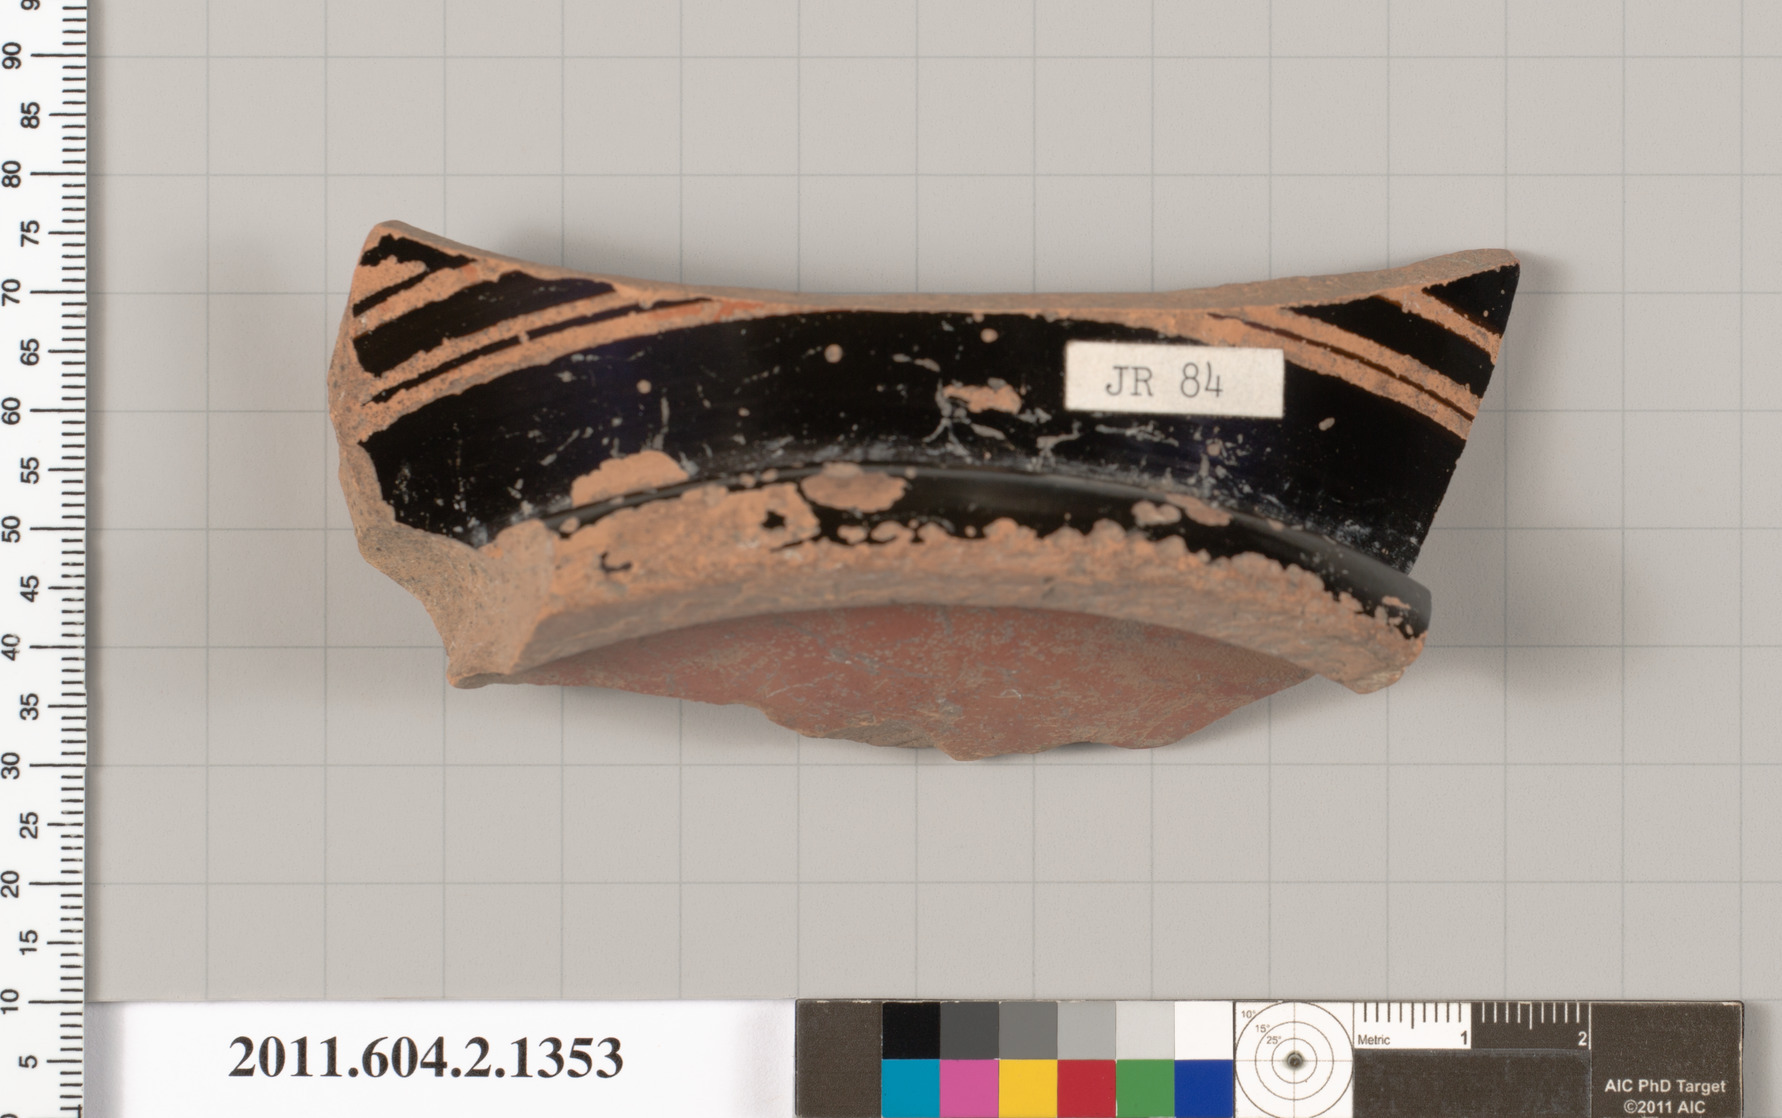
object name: skyphos fragment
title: Terracotta fragment of a skyphos (deep drinking cup)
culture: greek, attic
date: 467-435 BCE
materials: terracotta